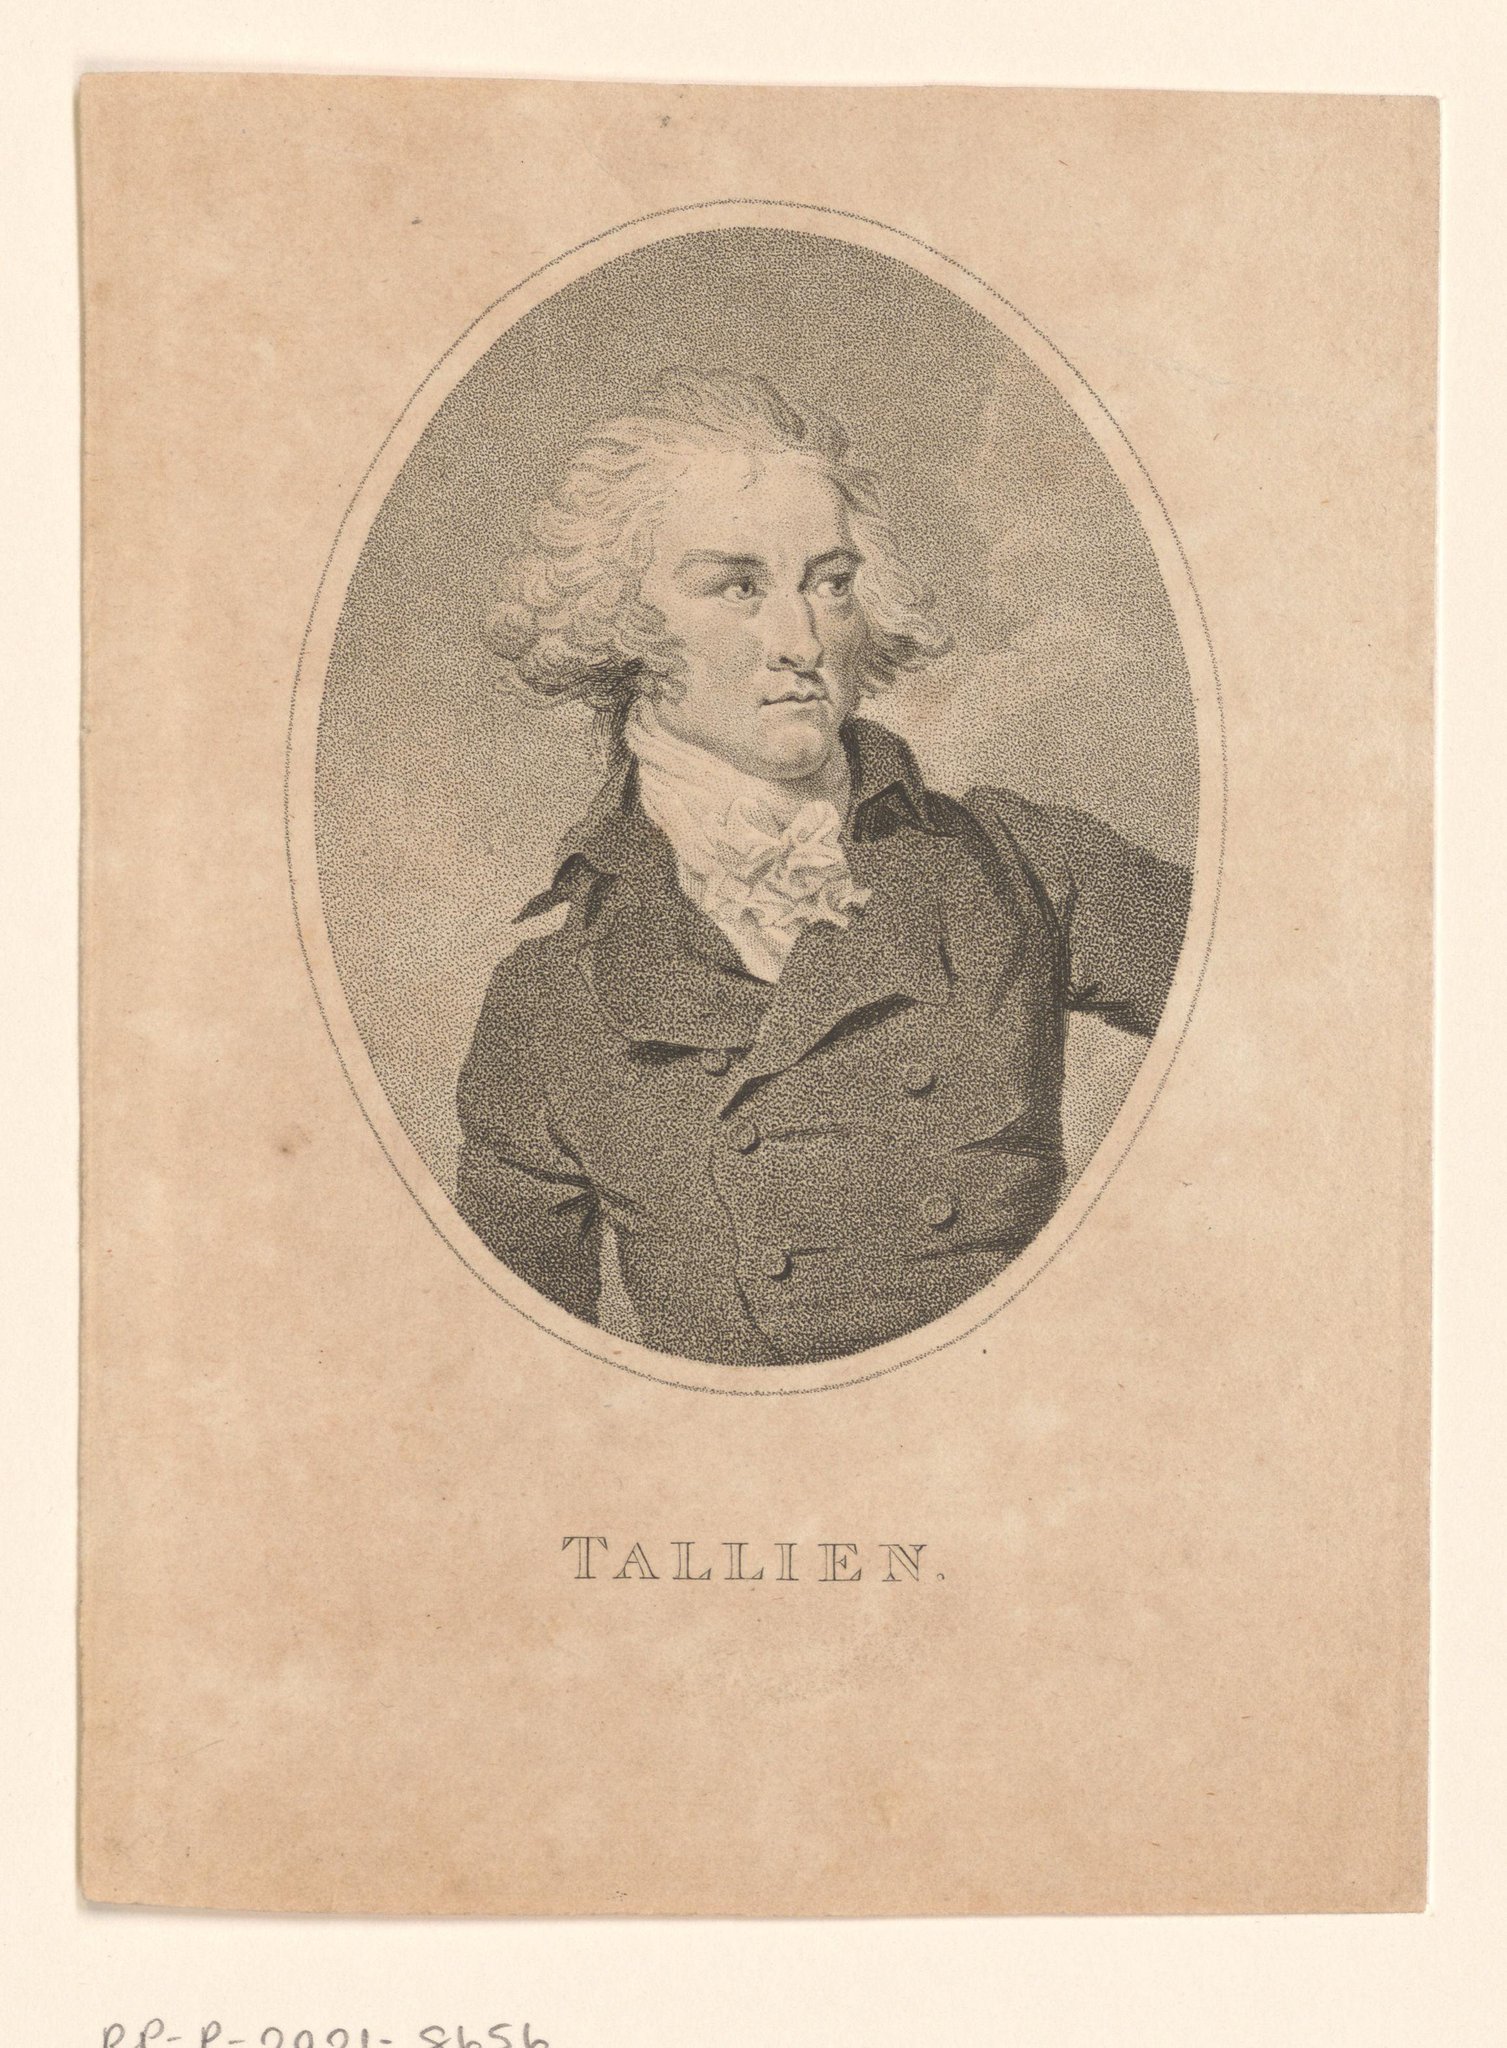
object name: print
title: Portret van Jean-Lambert Tallien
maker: Anonymous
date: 1792-1825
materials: paper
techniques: etching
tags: paris, historical persons, politician, e.g. party leader